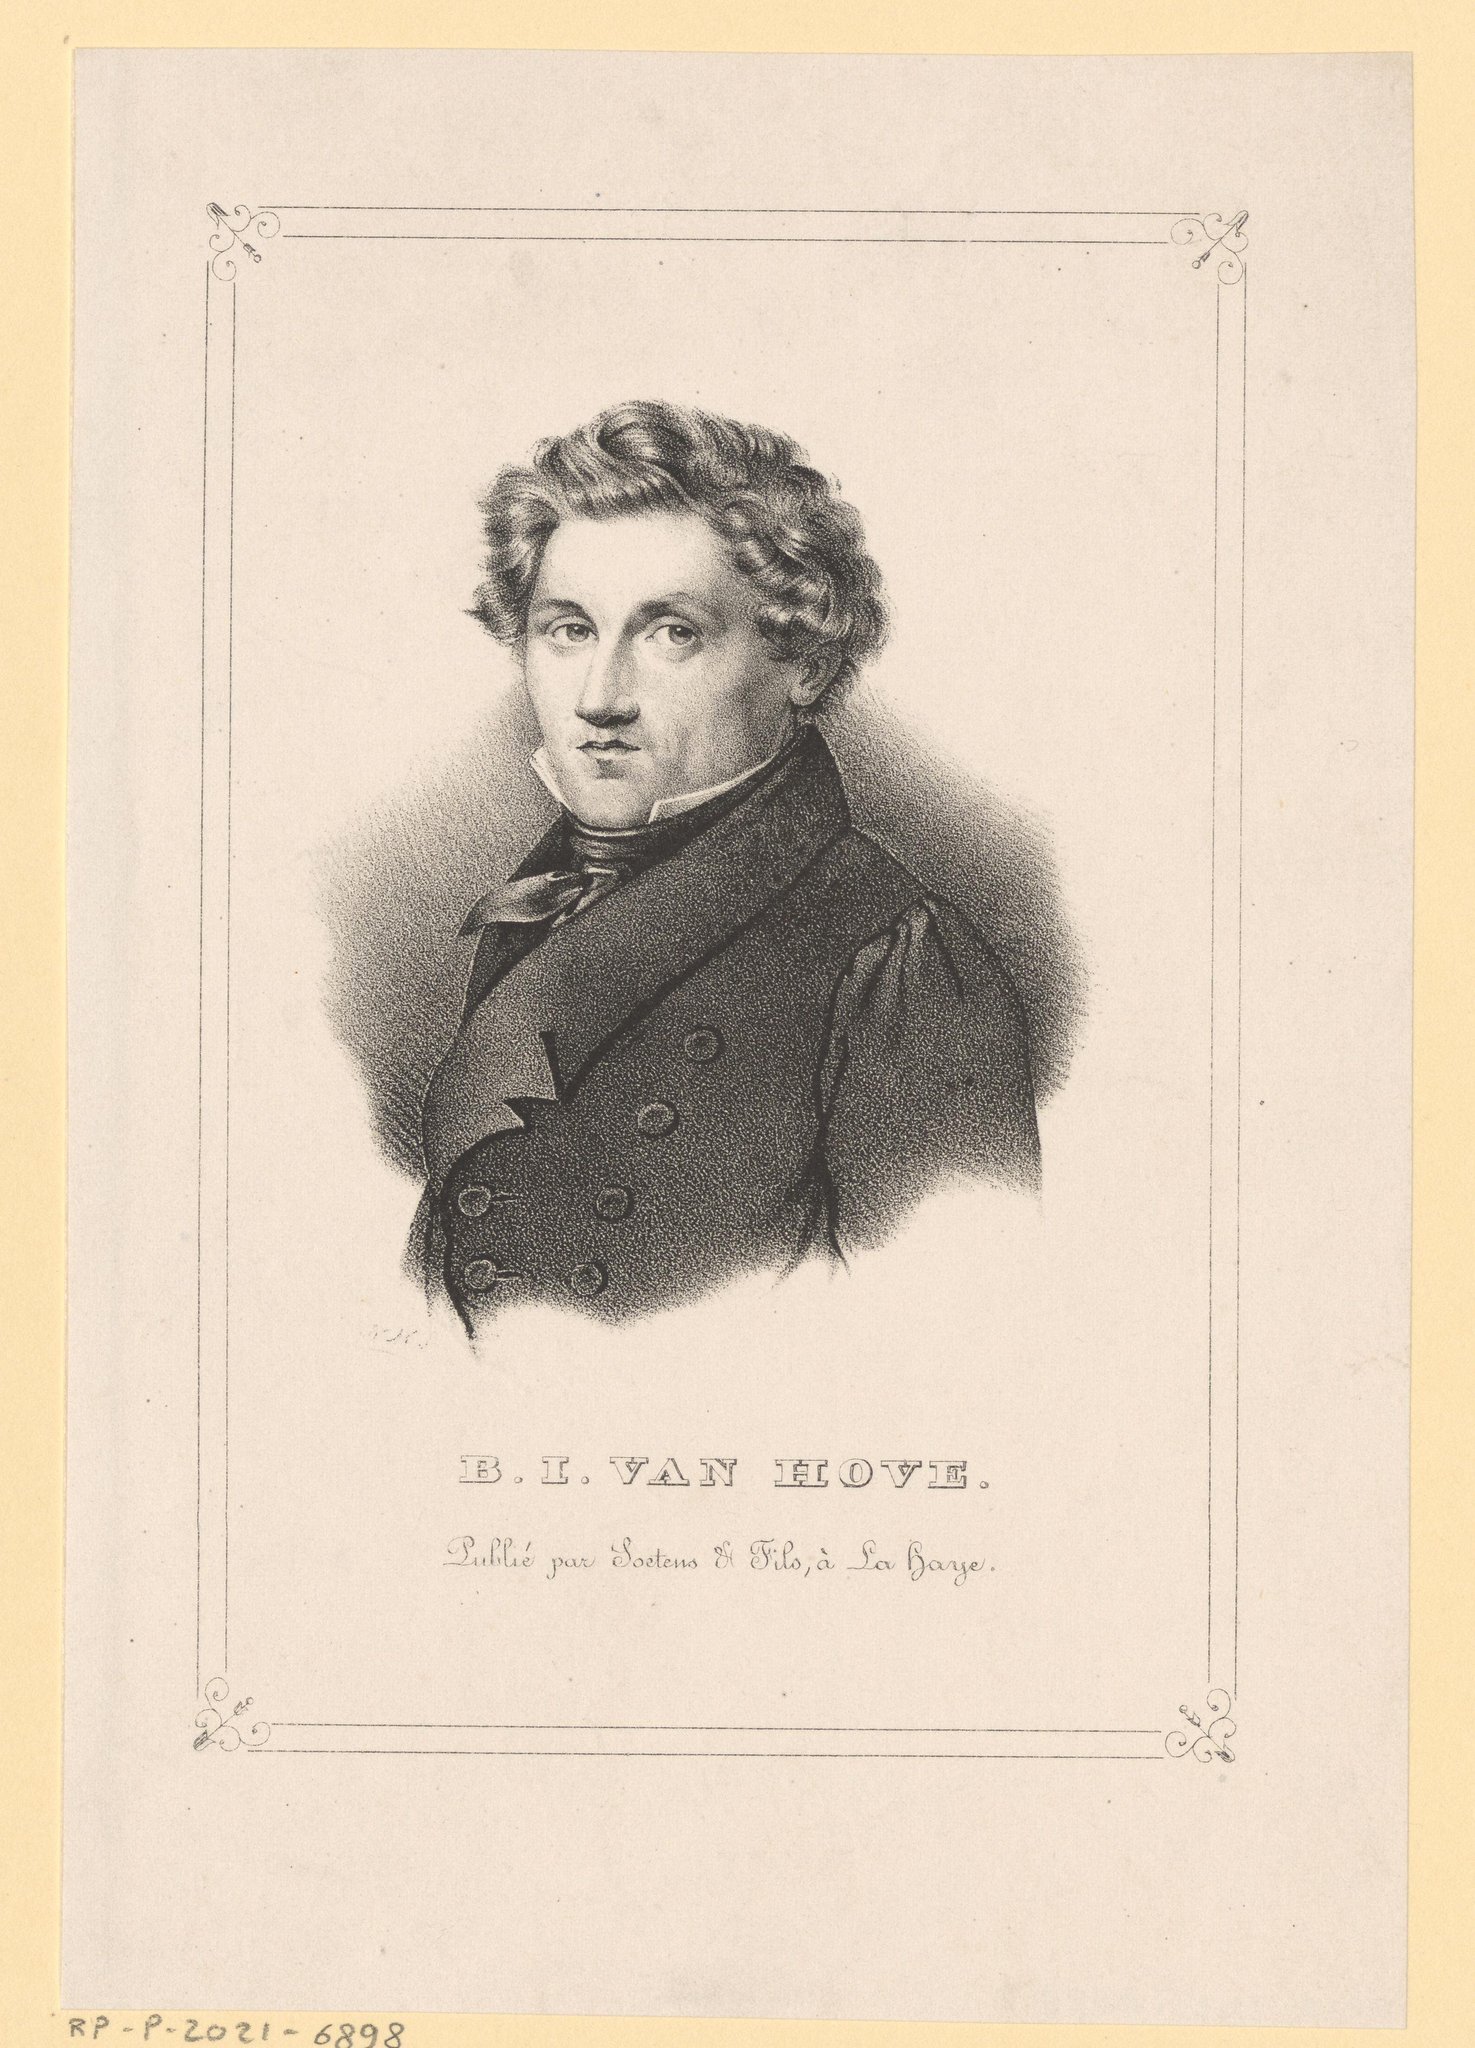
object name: print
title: Portret van Bartholomeus Johannes van Hove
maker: nicolaas martinus schild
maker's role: draughtsman, print maker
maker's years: 1822-1840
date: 1837-1840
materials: paper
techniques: lithograph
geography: the hague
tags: the hague, painter, print maker, draughtsman, bartholomeus johannes van hove, historical persons, portrait, self-portrait of painter